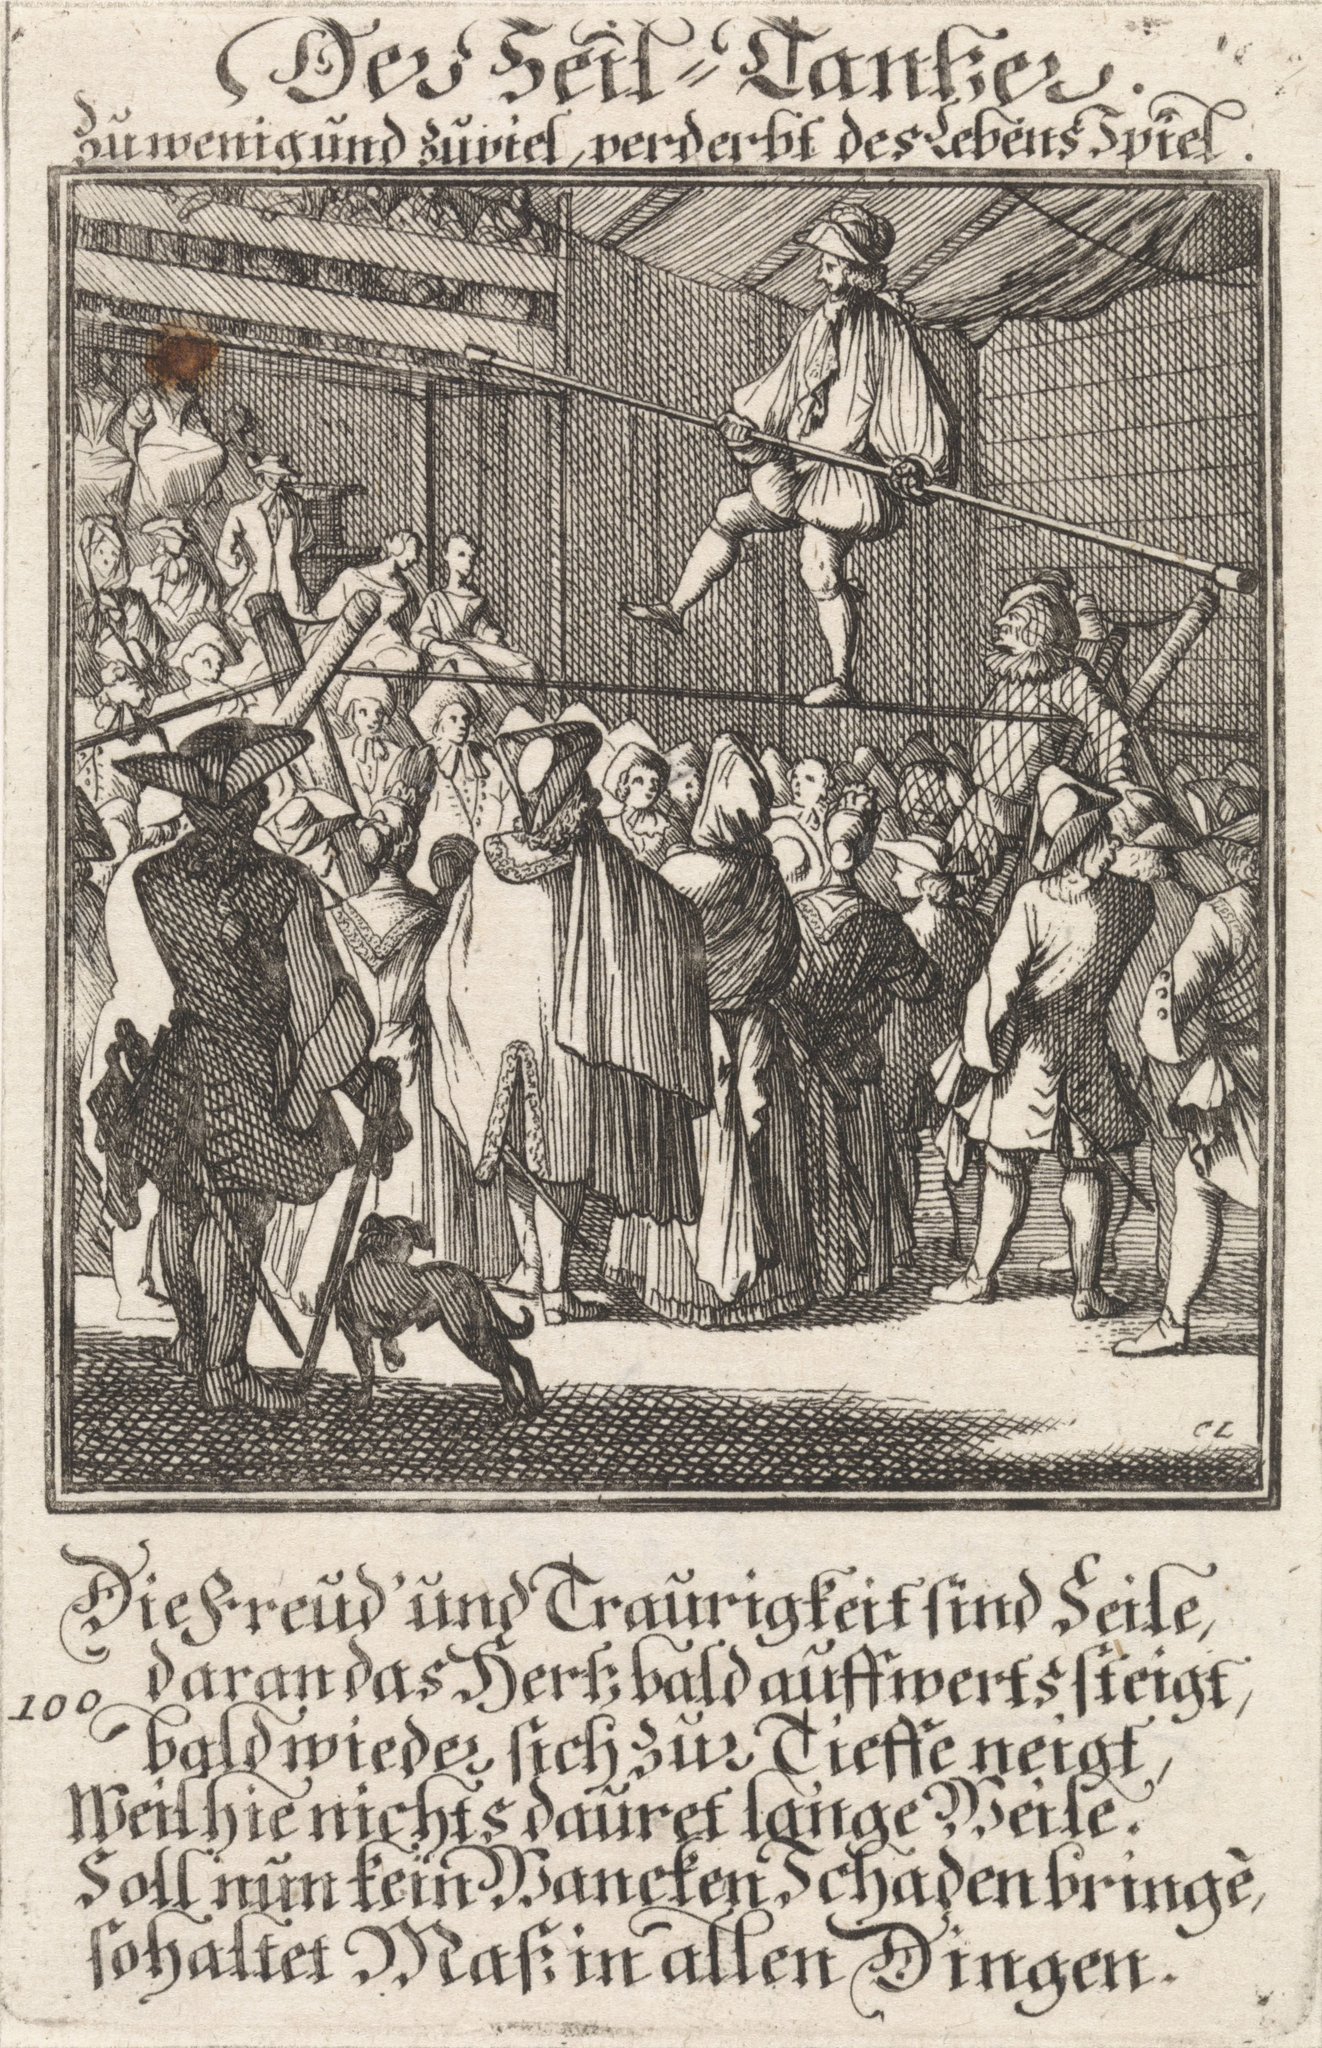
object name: book illustration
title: Koorddanser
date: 1711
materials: paper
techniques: etching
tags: tight-ropewalker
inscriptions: collector's mark: Lugt 2228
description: Illustratie uit: Sancta Clara, Abraham à. Etwas für Alle, das ist: Eine kurtze Beschreibung allerley Stands- Ambts- und Gewerbs-Persohnen (...), 3 delen (1699-1733). Würtzburg: Martin Frantz Hertz, 1711, dl. III, p. 936. Het betreft hier de tweede druk van deel III.